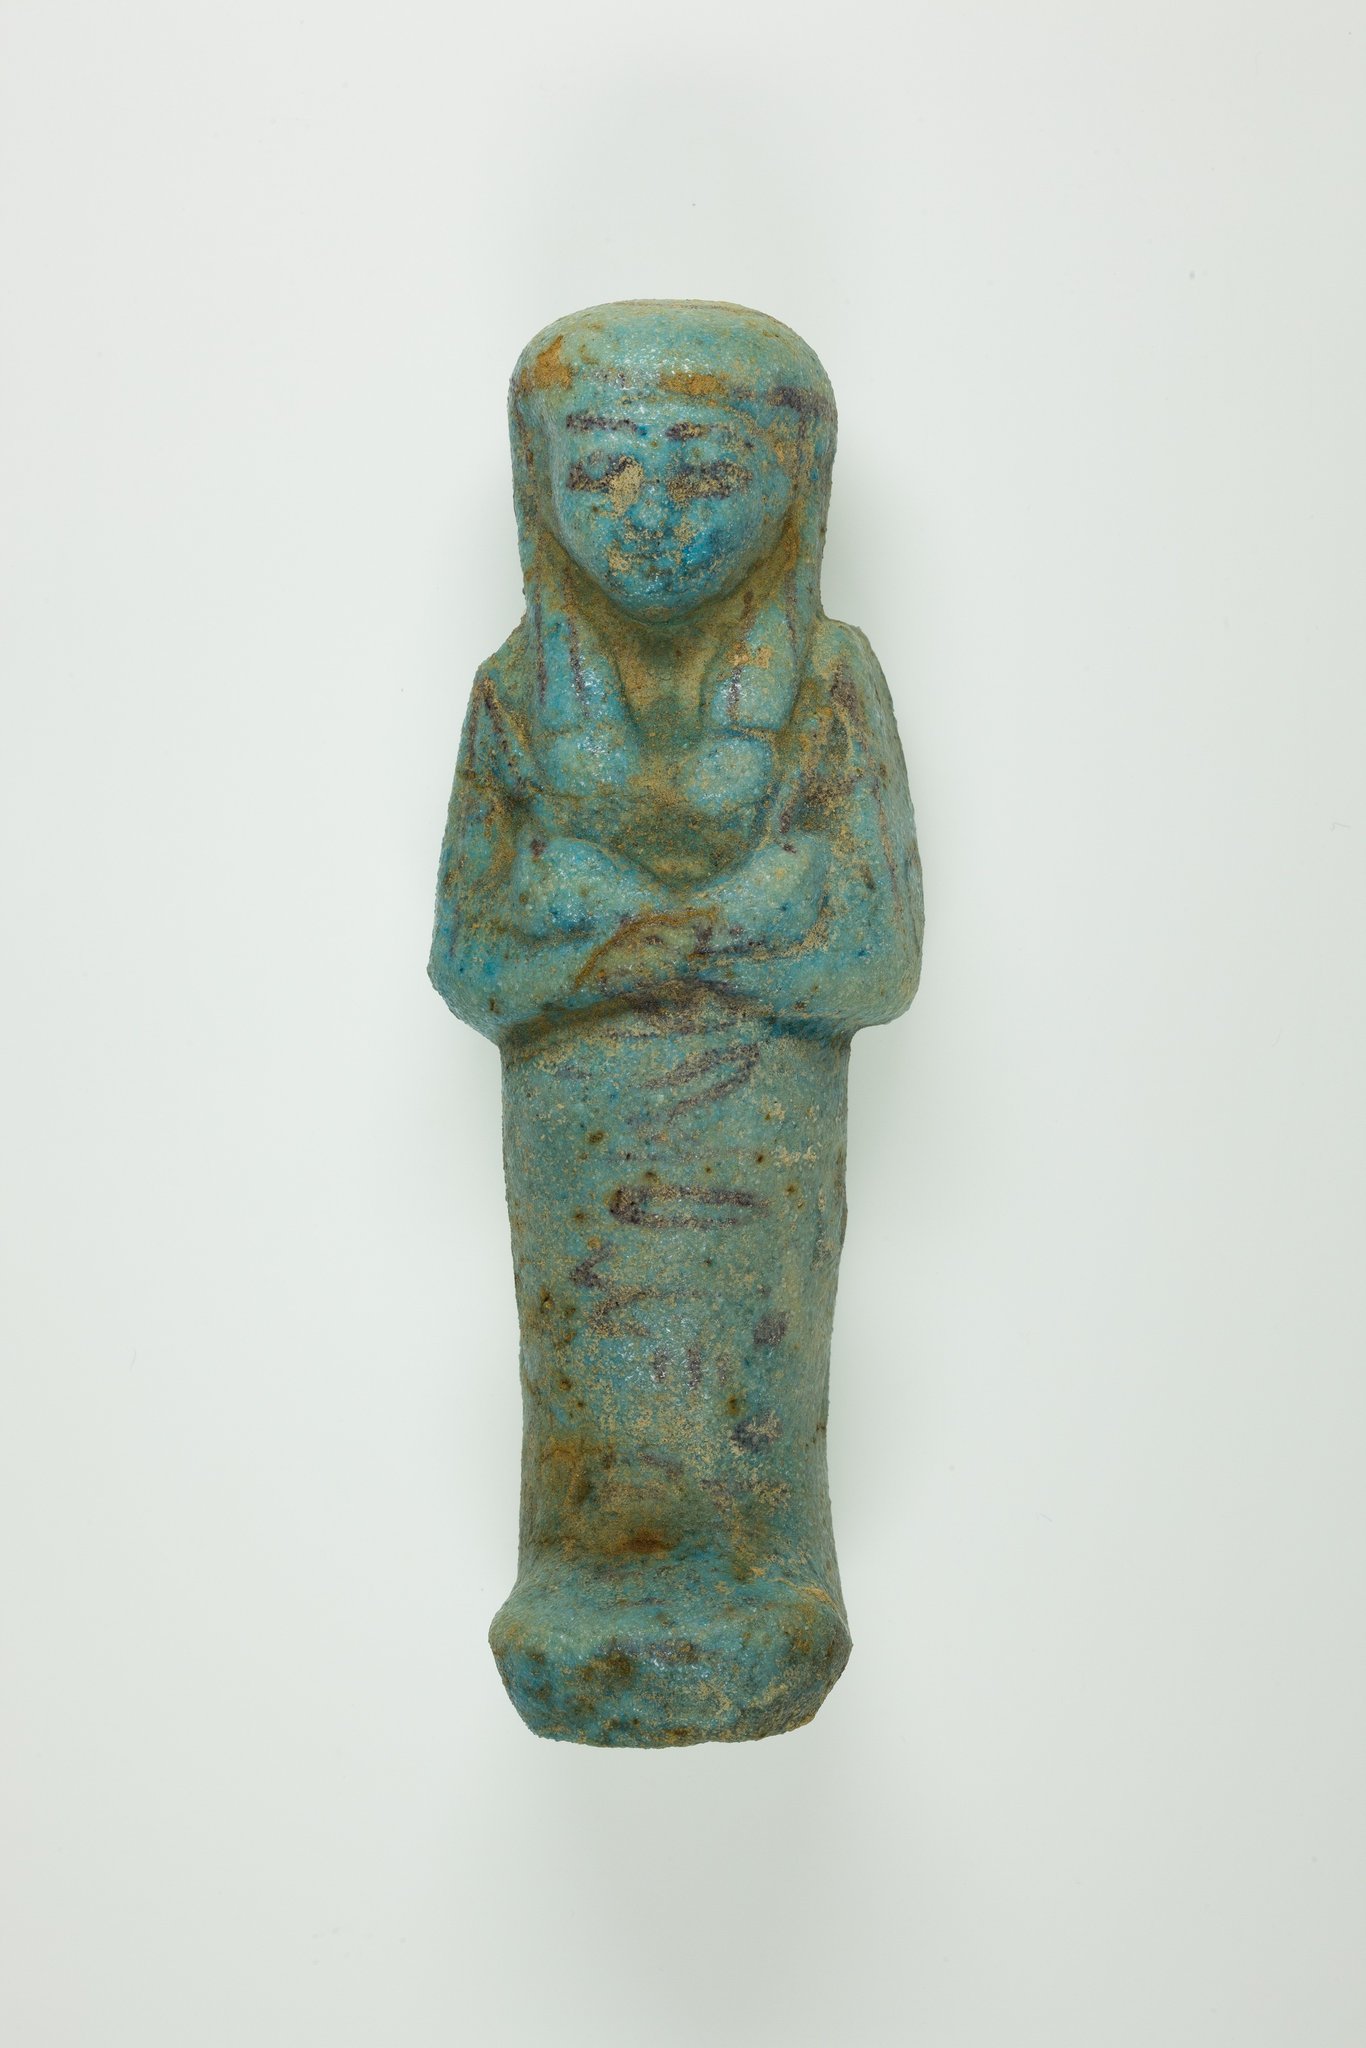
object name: worker shabti, henettawy c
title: Worker Shabti of Henettawy (C), Daughter of Isetemkheb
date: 990-970 BCE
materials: faience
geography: egypt